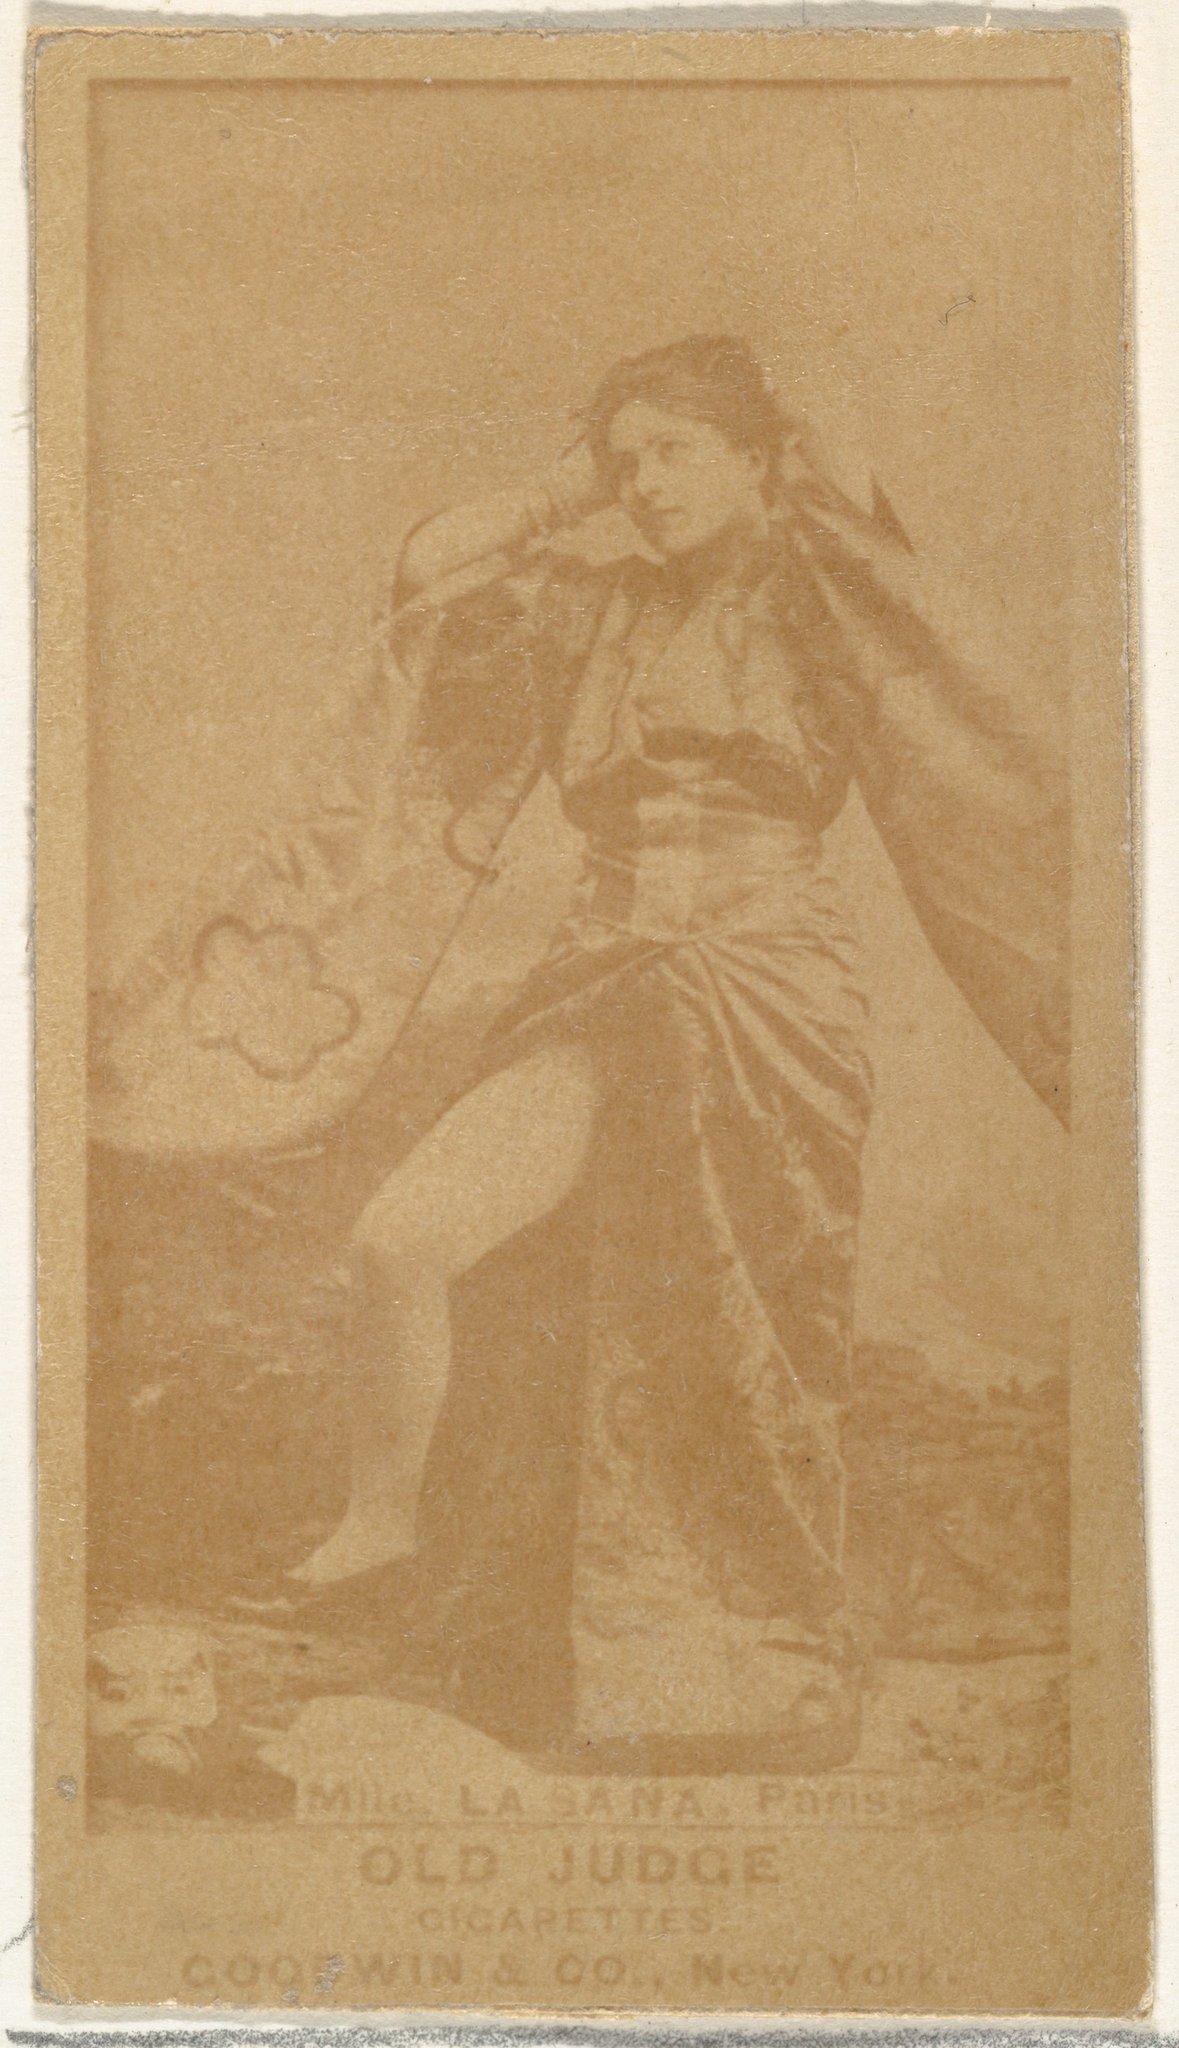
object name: photograph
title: Mlle. La Sana, Paris, from the Actors and Actresses series (N171) for Old Judge Cigarettes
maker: goodwin & company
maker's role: publisher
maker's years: 1850-1950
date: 1886-1890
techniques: albumen silver print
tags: portraits,women,actresses